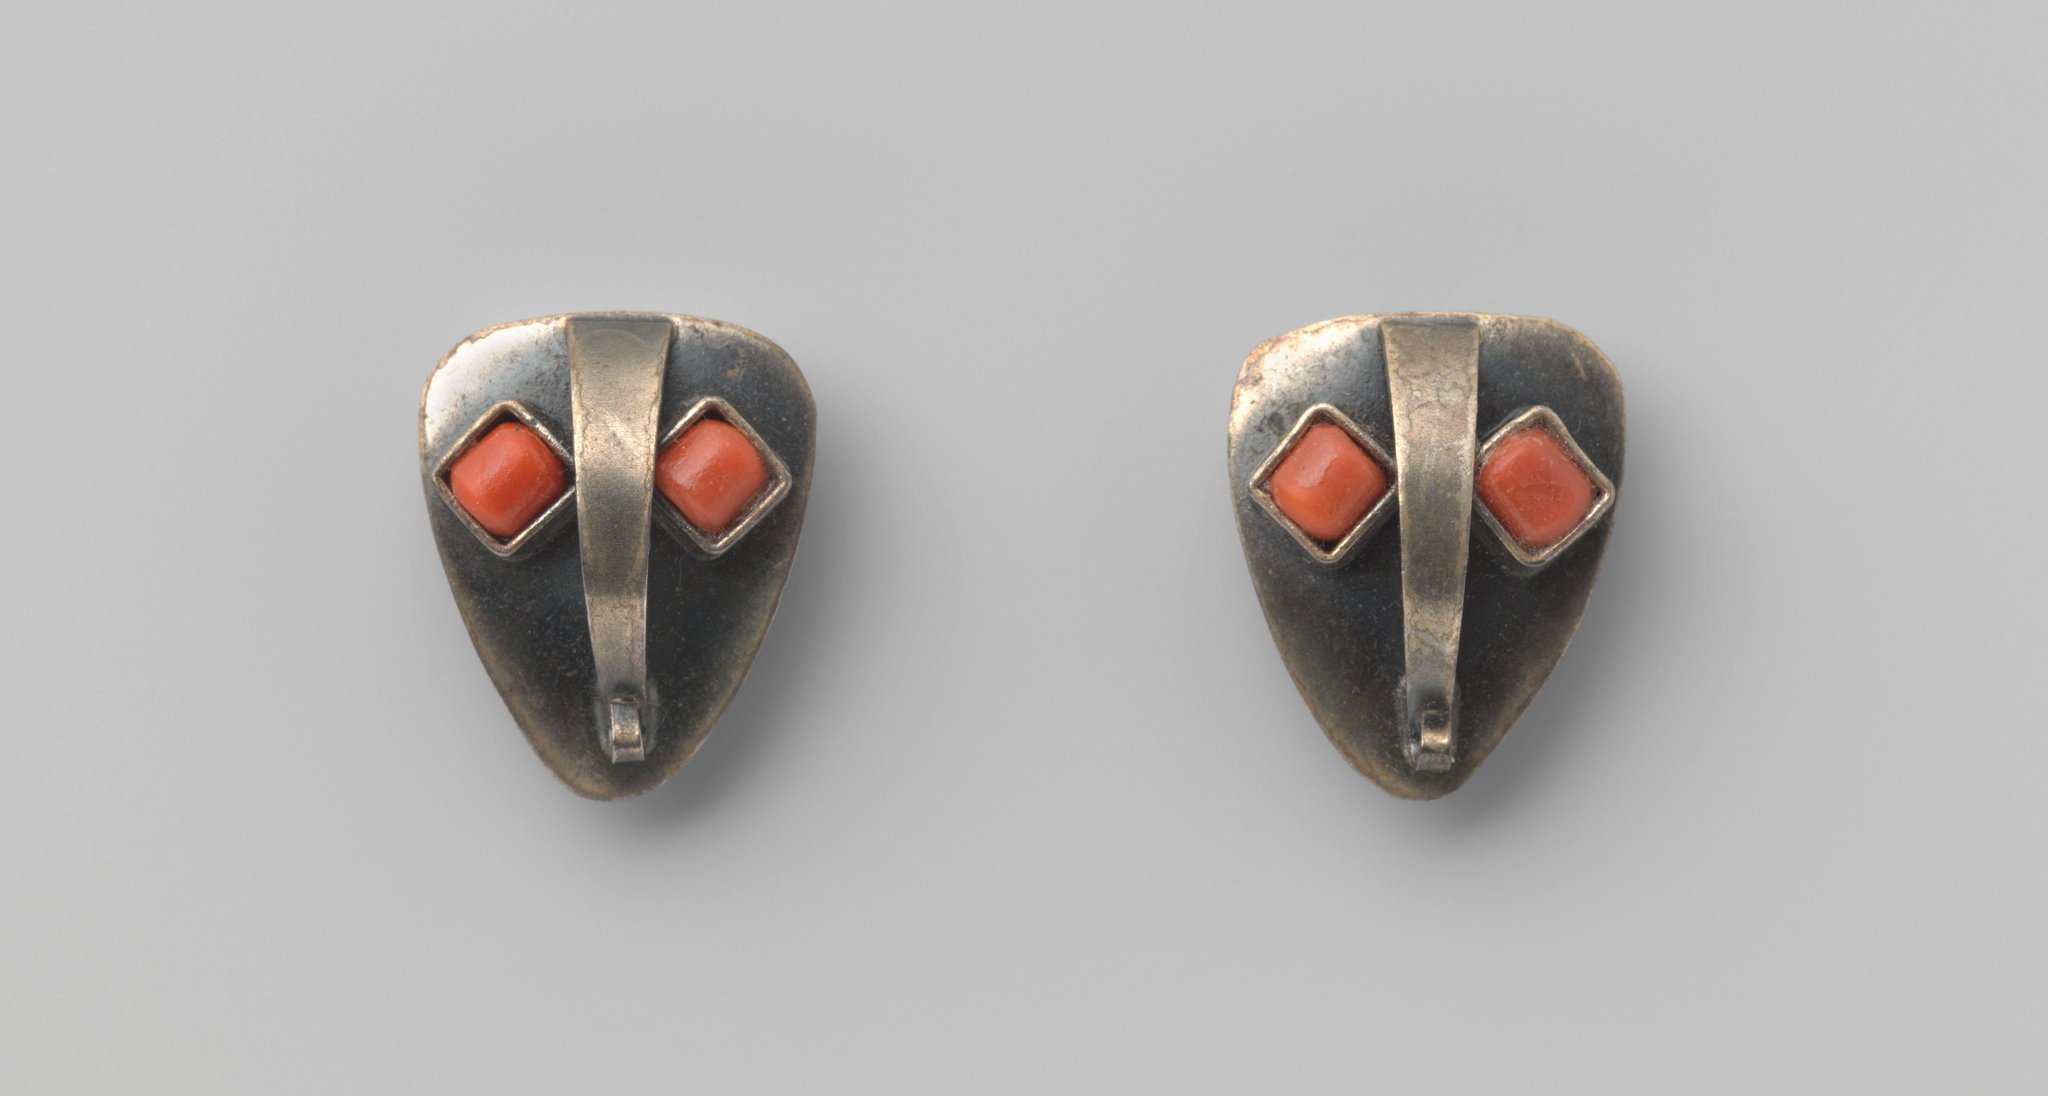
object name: earring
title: Oorclip van zilverkleurig metaal en twee kralen van koraalkleurige paste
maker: Anonymous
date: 1950-1970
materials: metal, paste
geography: netherlands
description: De oorclip is driehoekig en licht bollend van vorm, met afgeronde hoeken. Van middenboven tot in de onderste hoek loopt een lichtgebogen taps toelopend stuk metaal dat eindigt in een cirkel. Aan weerszijden van dit stuk metaal zit in een ruitvormige zetting een ronde kraal van koraalkleurige paste. De kralen zijn evenwijdig ten opzichte van elkaar geplaatst.